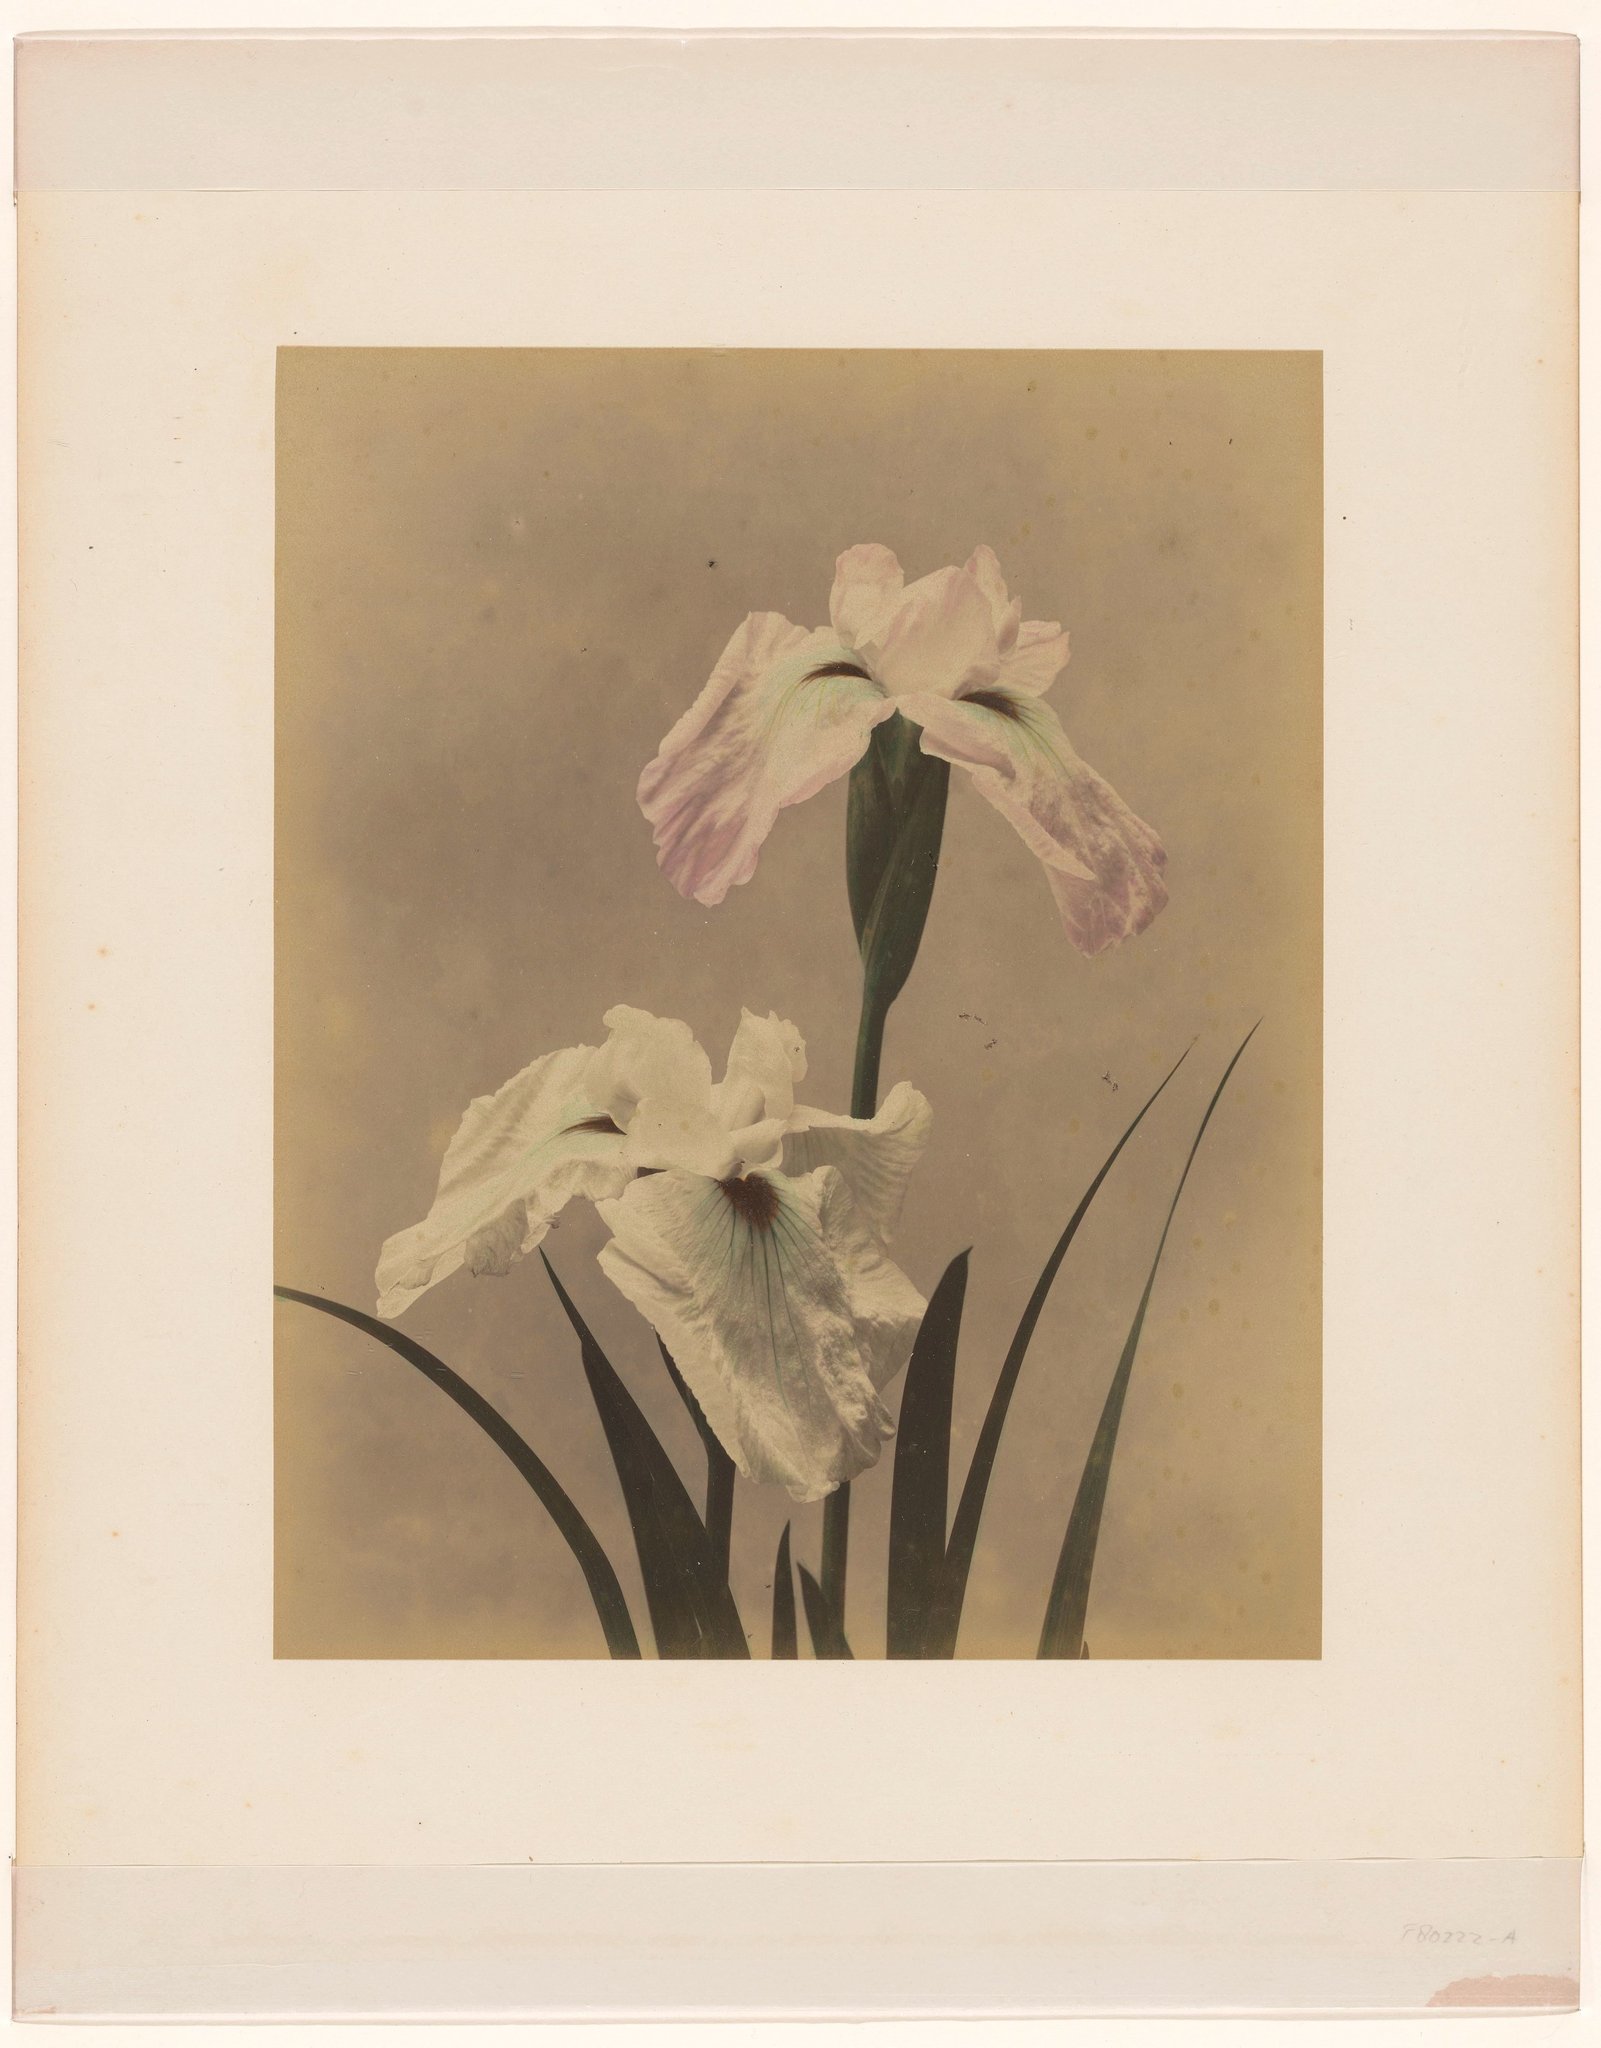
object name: photograph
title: Irissen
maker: Anonymous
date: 1855-1890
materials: cardboard, paper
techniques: albumen print, hand coloring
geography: japan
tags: flowers, japan